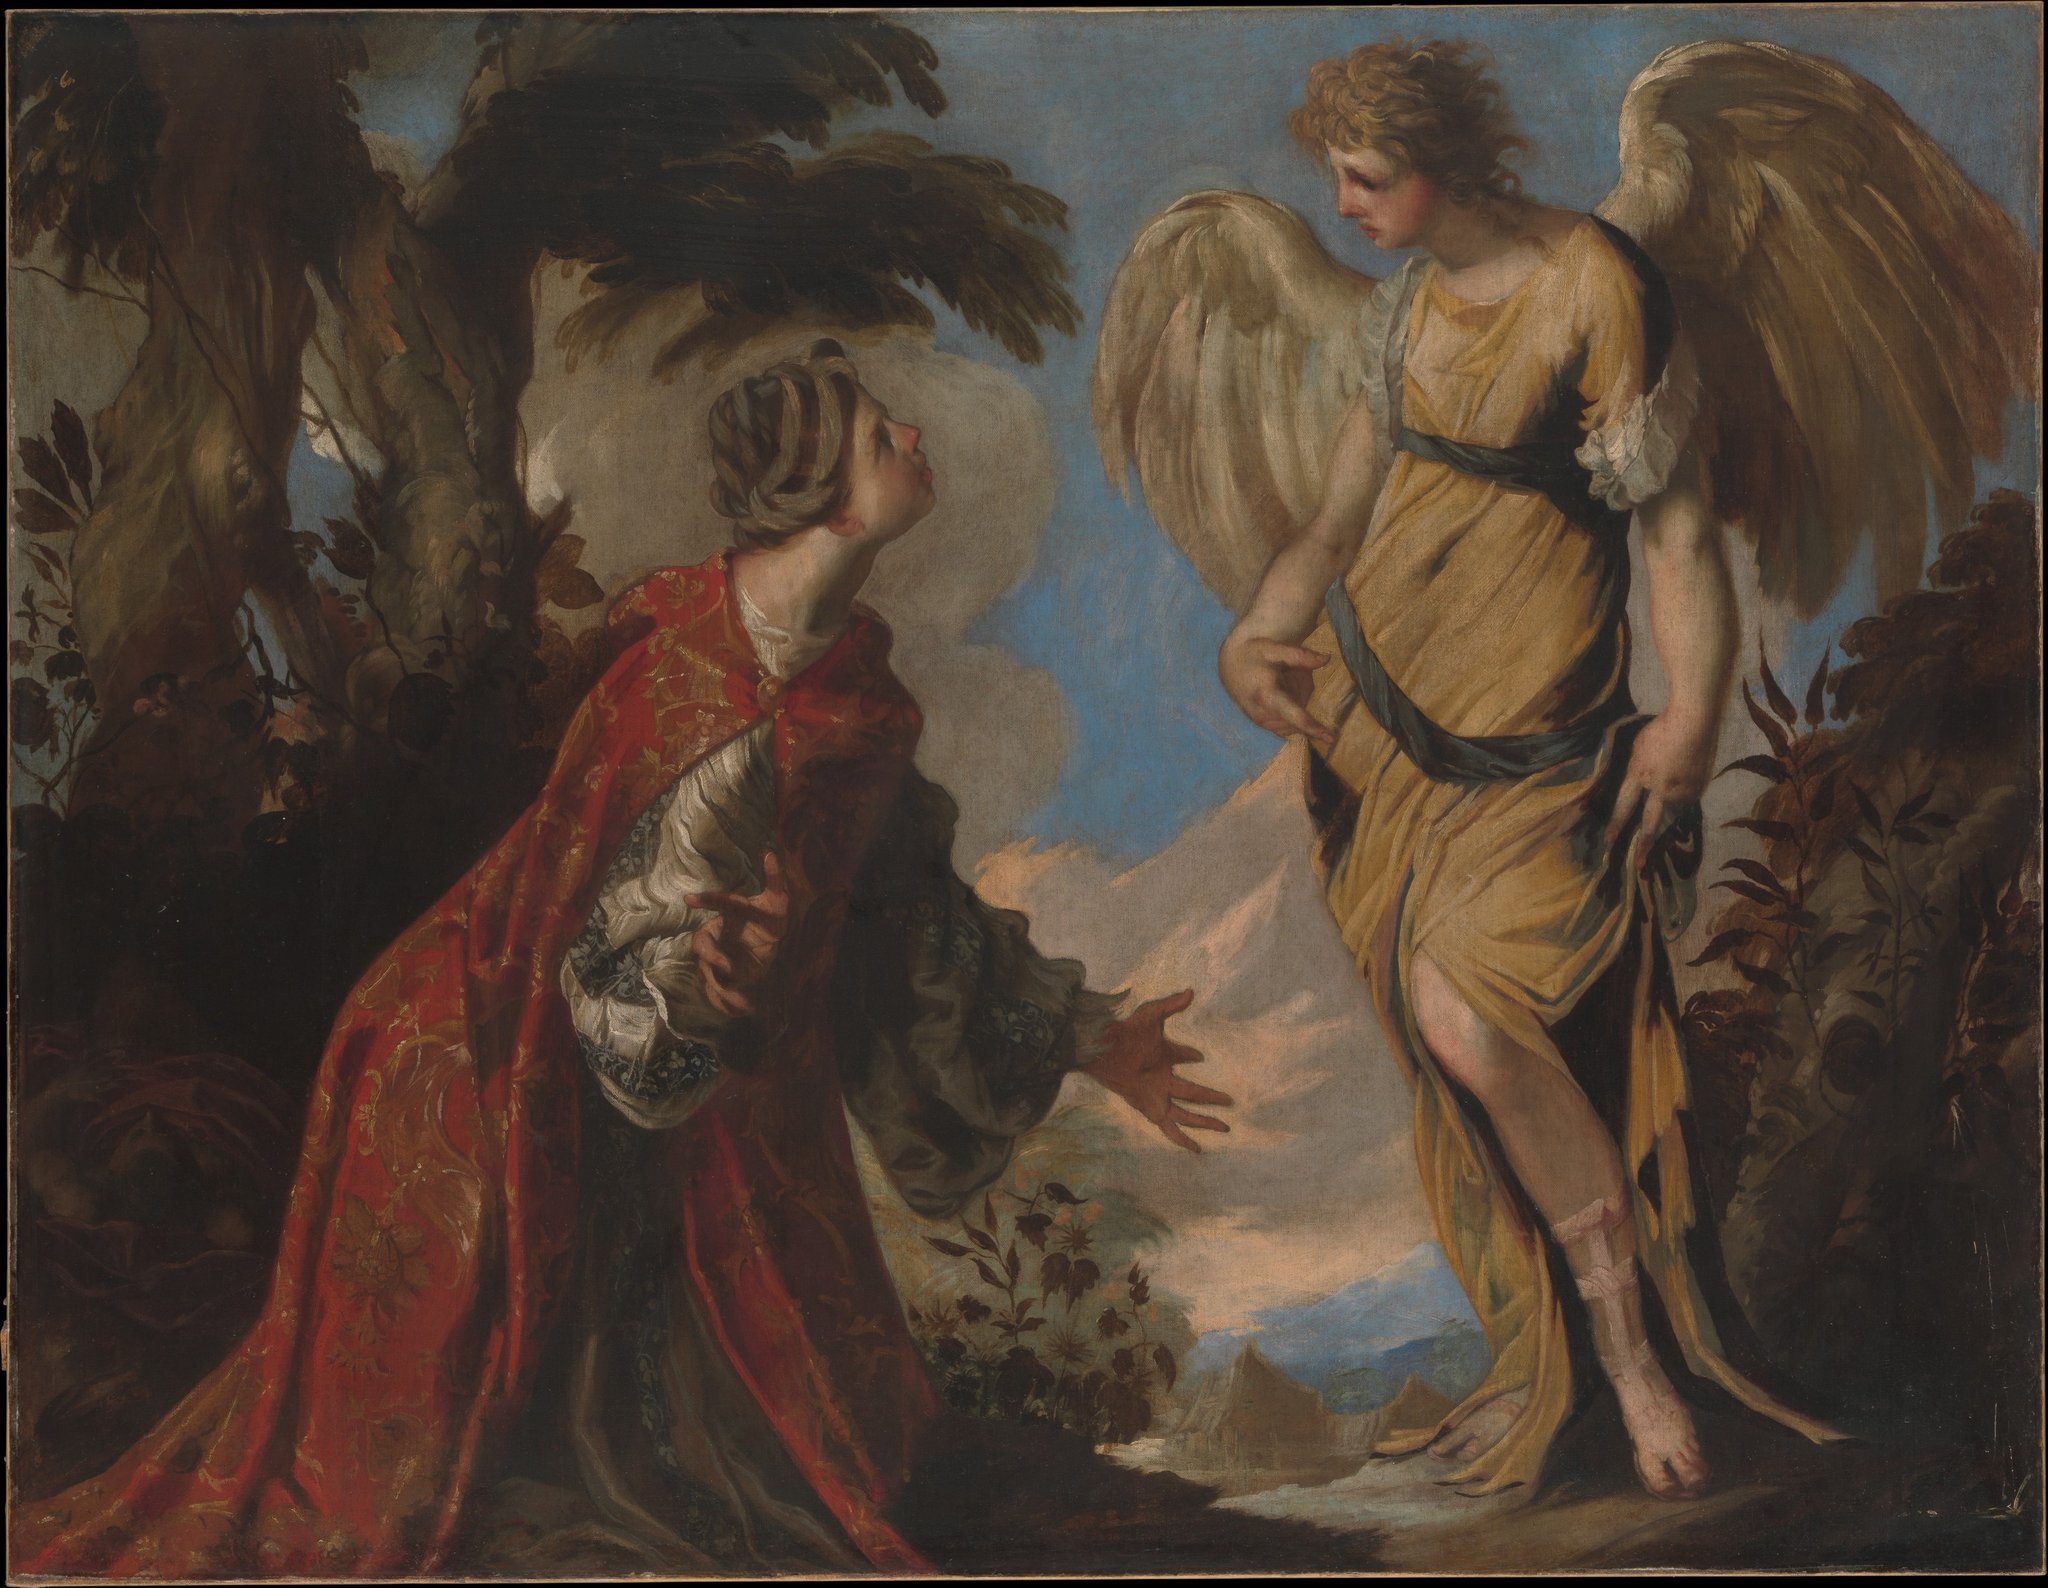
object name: painting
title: Hagar and the Angel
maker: francesco maffei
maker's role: artist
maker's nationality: italian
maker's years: 1605-1660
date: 1657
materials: canvas, oil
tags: women,angels